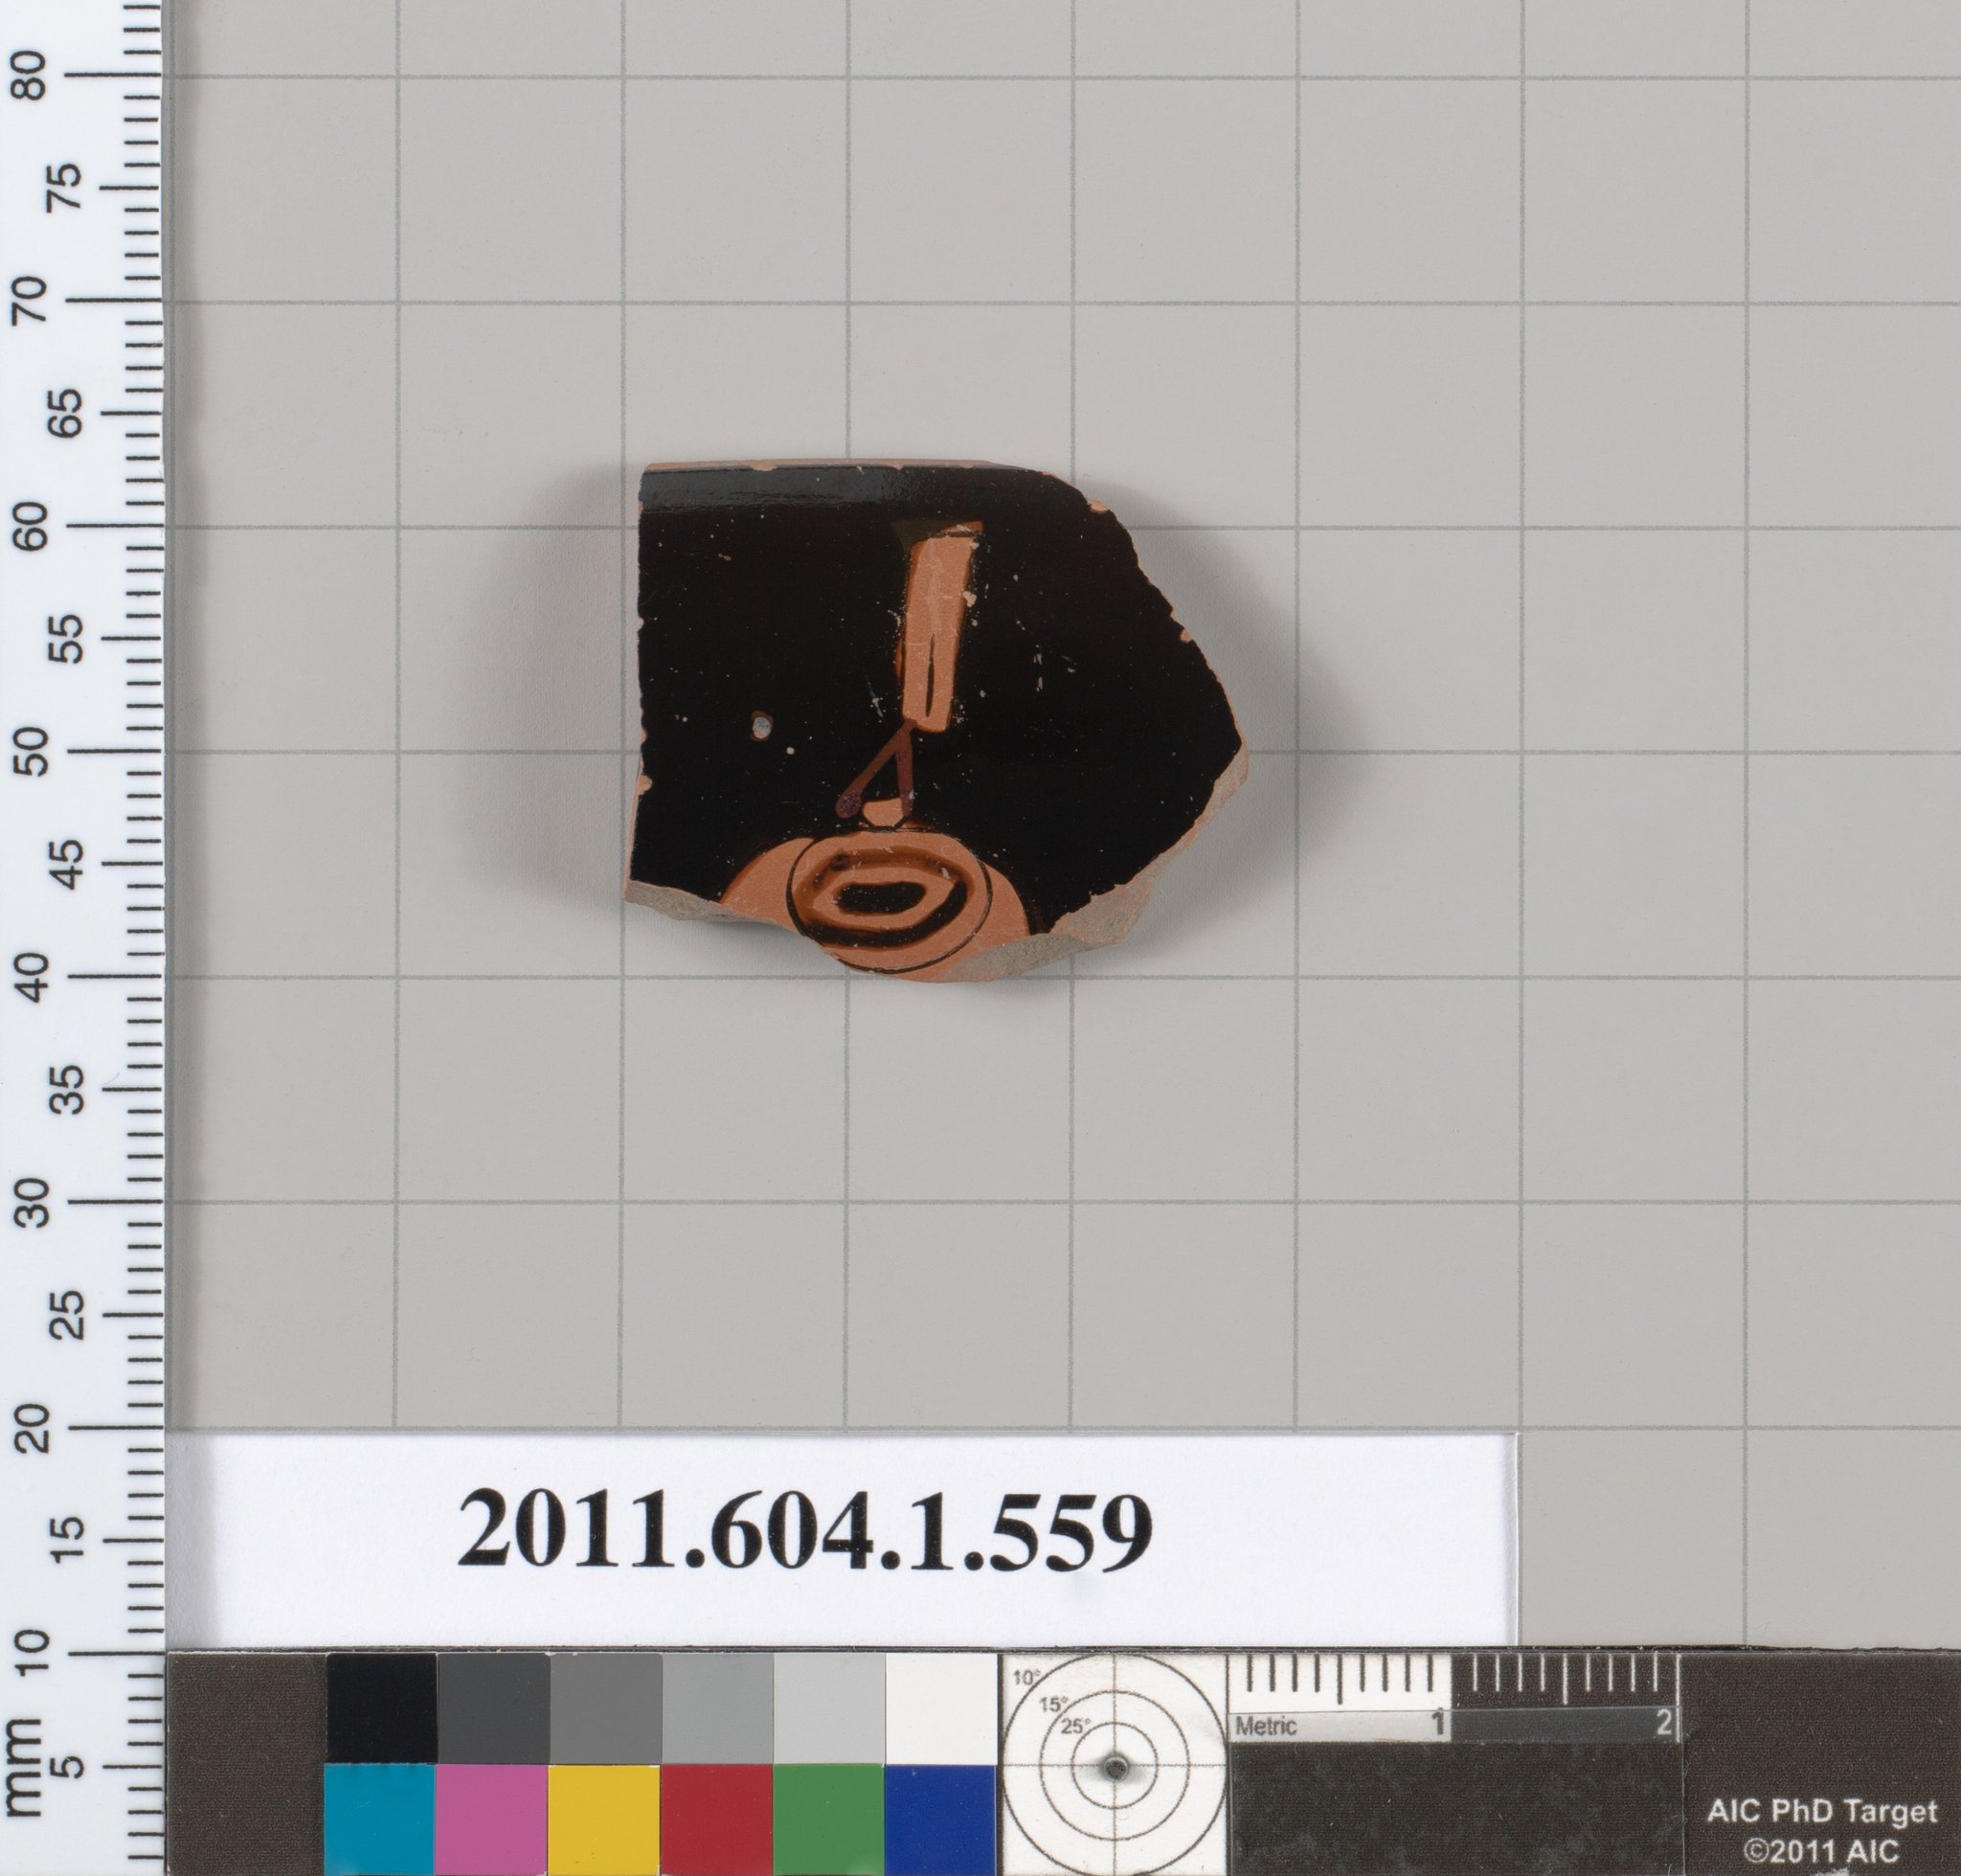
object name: kylix fragment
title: Terracotta rim fragment of a kylix (drinking cup)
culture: greek, attic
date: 480-470 BCE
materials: terracotta